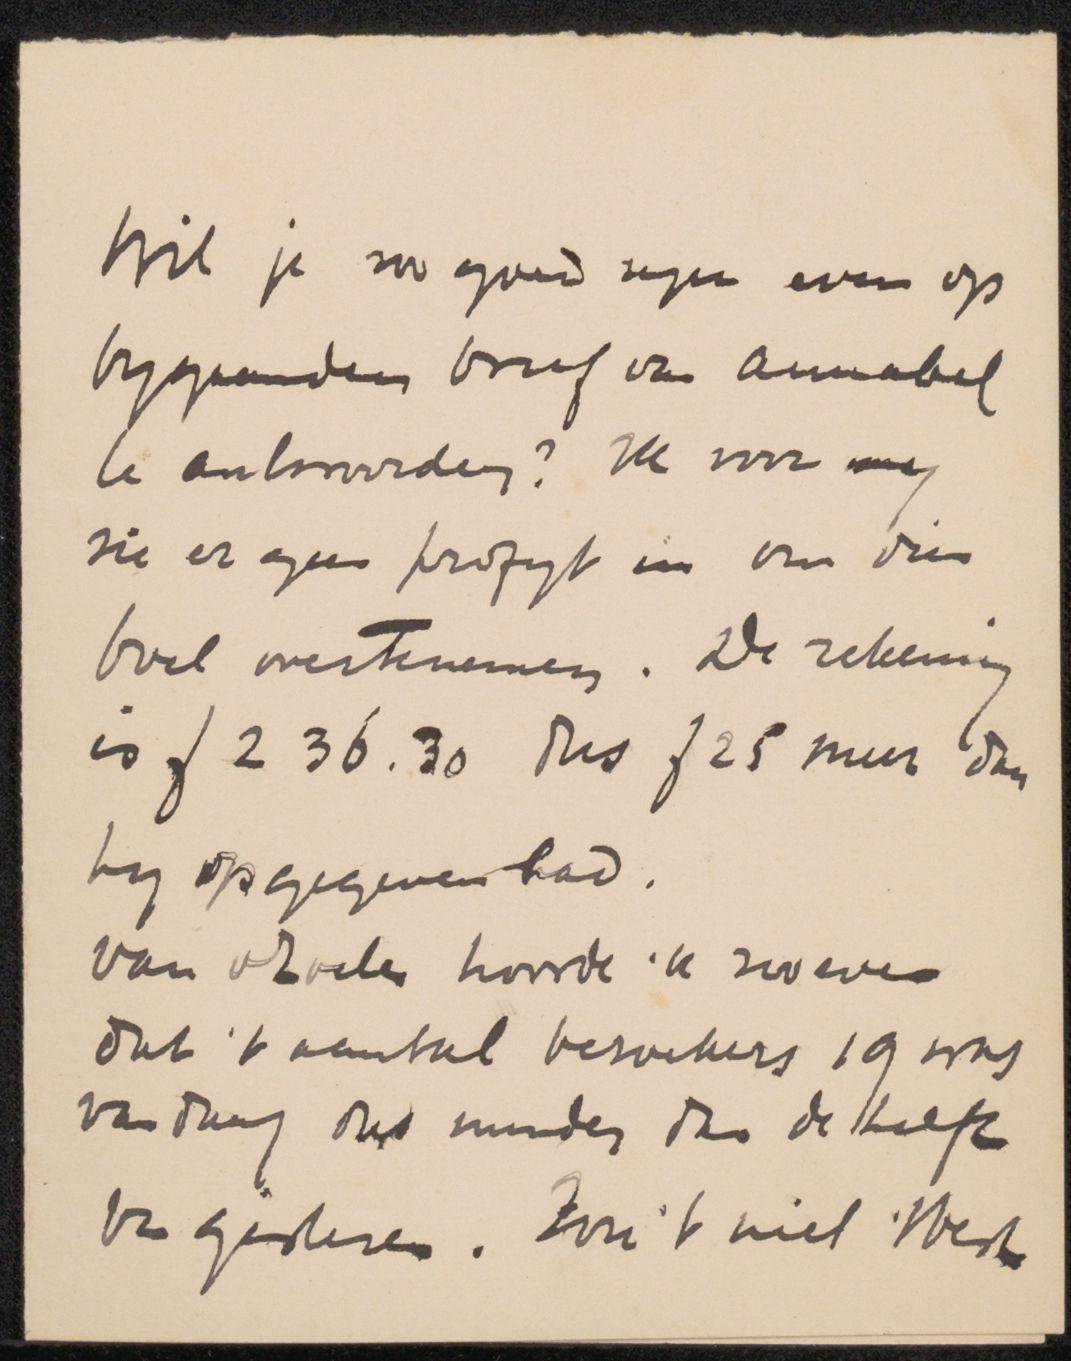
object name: letter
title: Brief aan Jan Veth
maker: willem witsen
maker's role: draughtsman, painter, print maker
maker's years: 1860-1923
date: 1887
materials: ink, paper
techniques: pen, writing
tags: designer, jan veth, the graphic arts, money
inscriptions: collector's mark: ‘RPK’